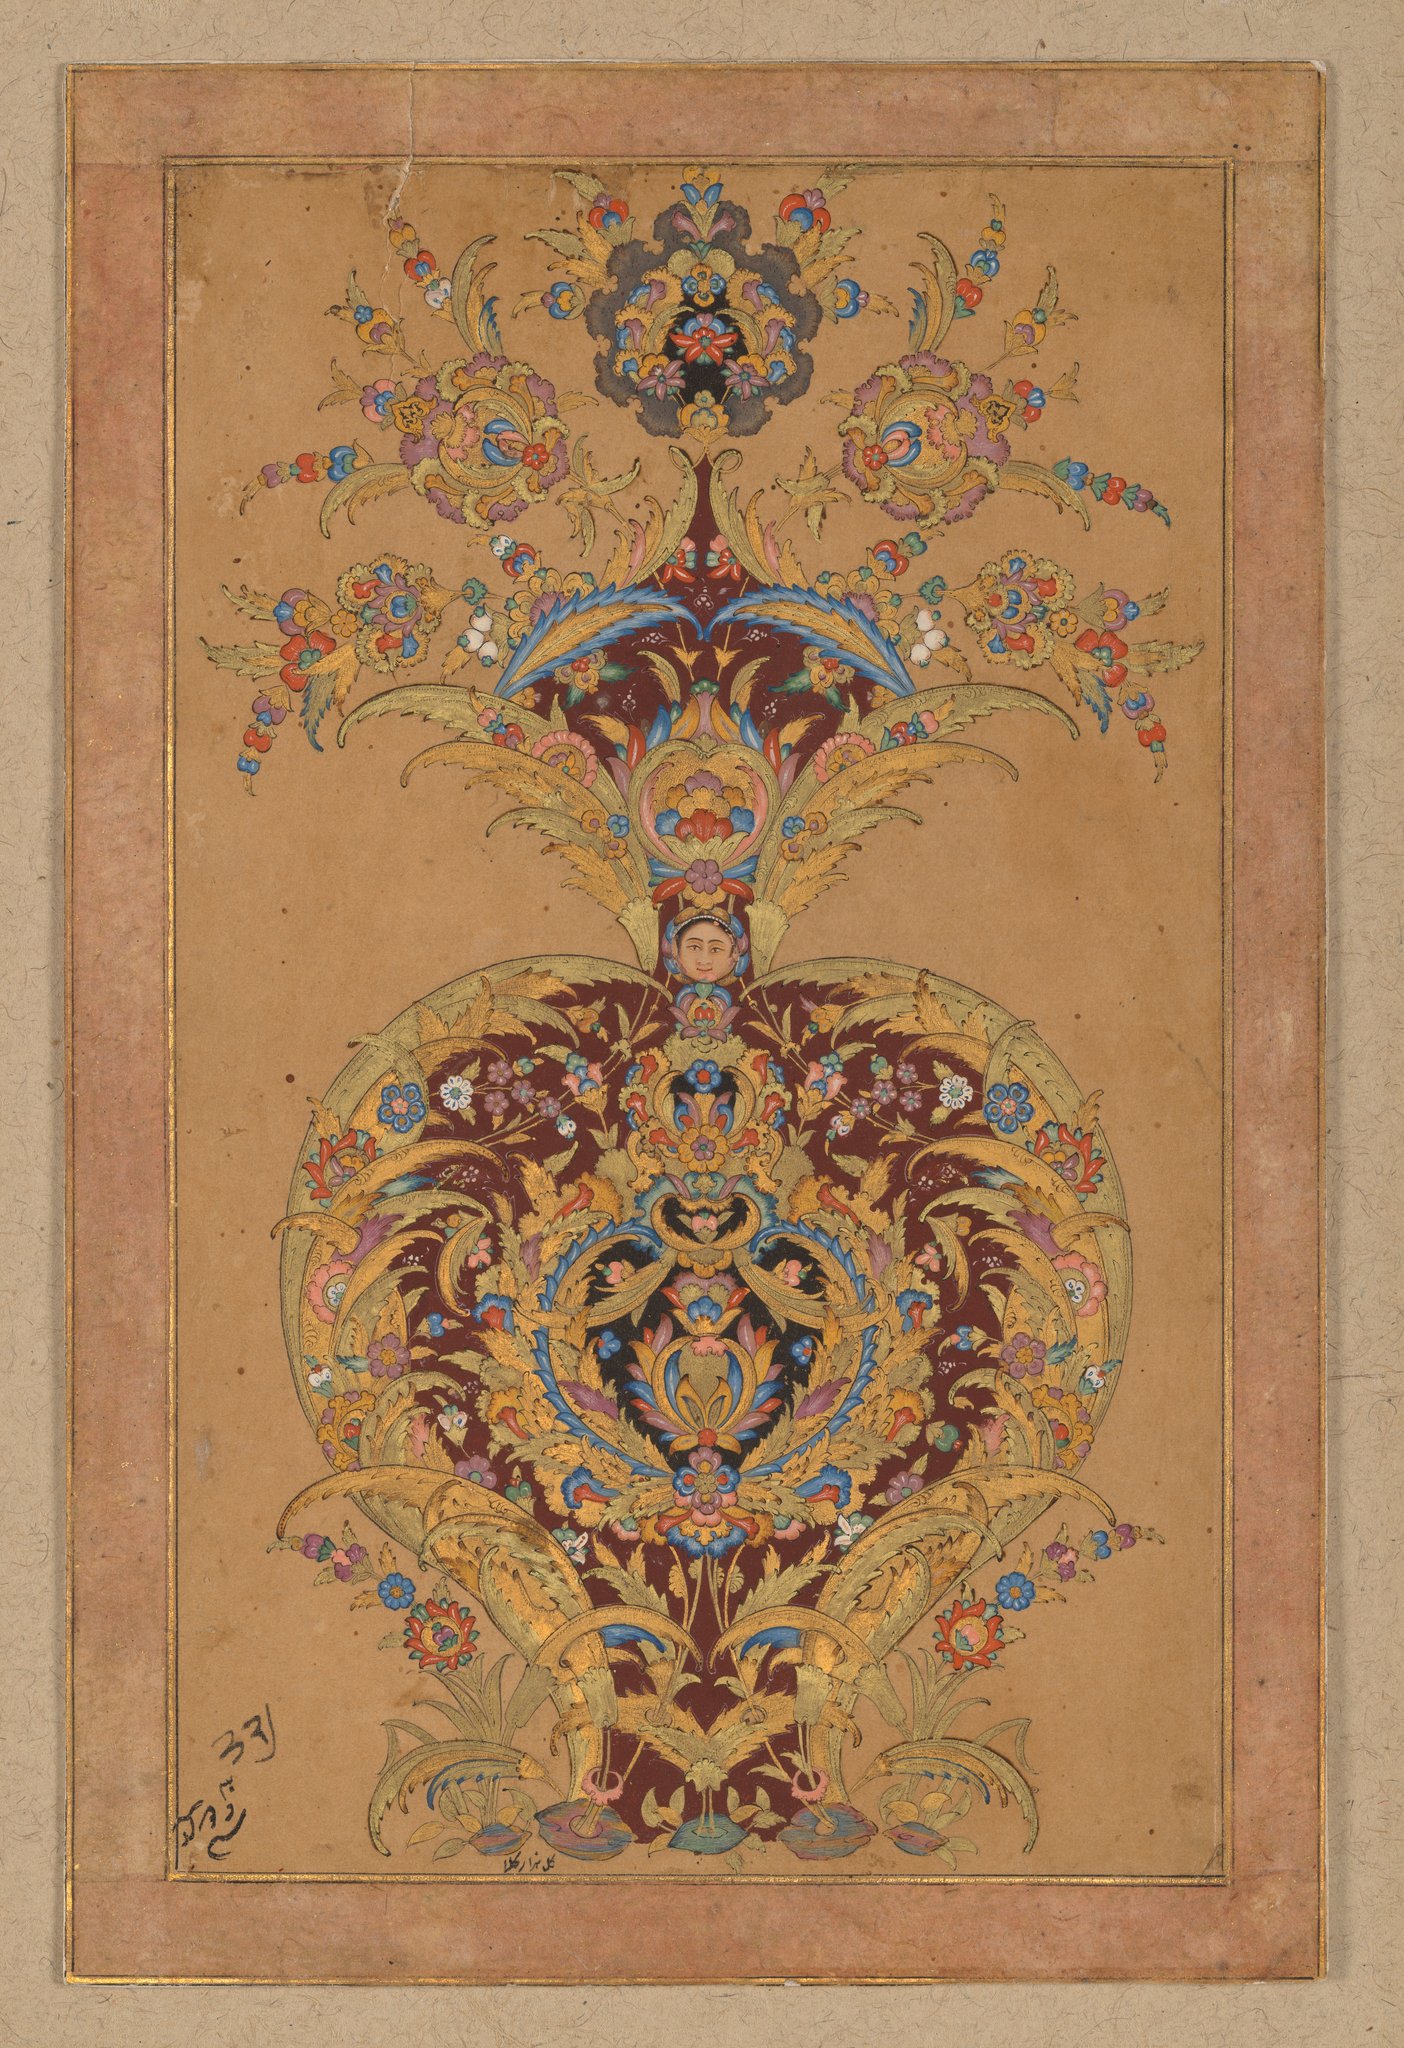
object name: illustrated album leaf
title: Illumination in the Form of a Vase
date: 1601-1633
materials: gold, ink, paper, watercolor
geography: india